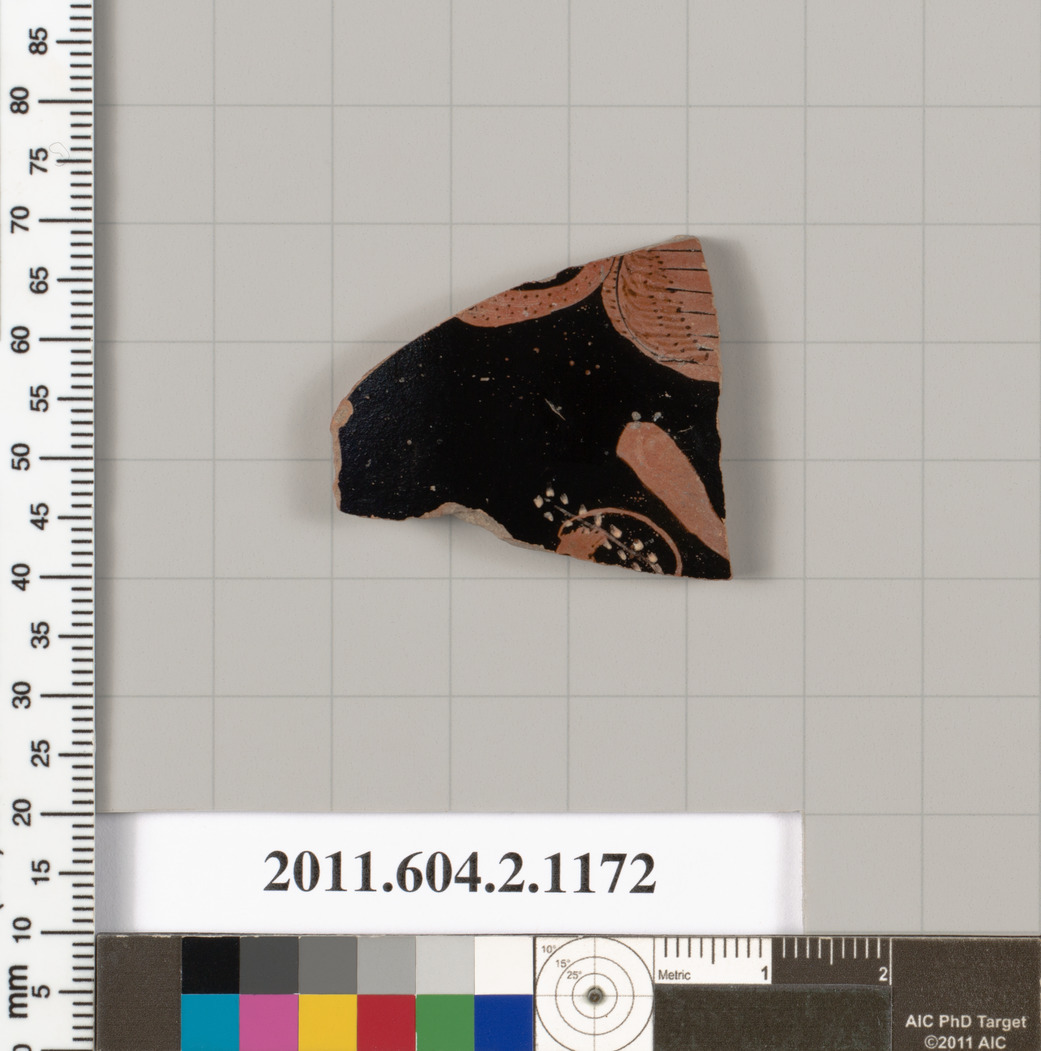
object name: lekanis fragment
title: Terracotta fragment of a lekanis lid (covered dish)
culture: greek, attic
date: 450-426 BCE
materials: terracotta